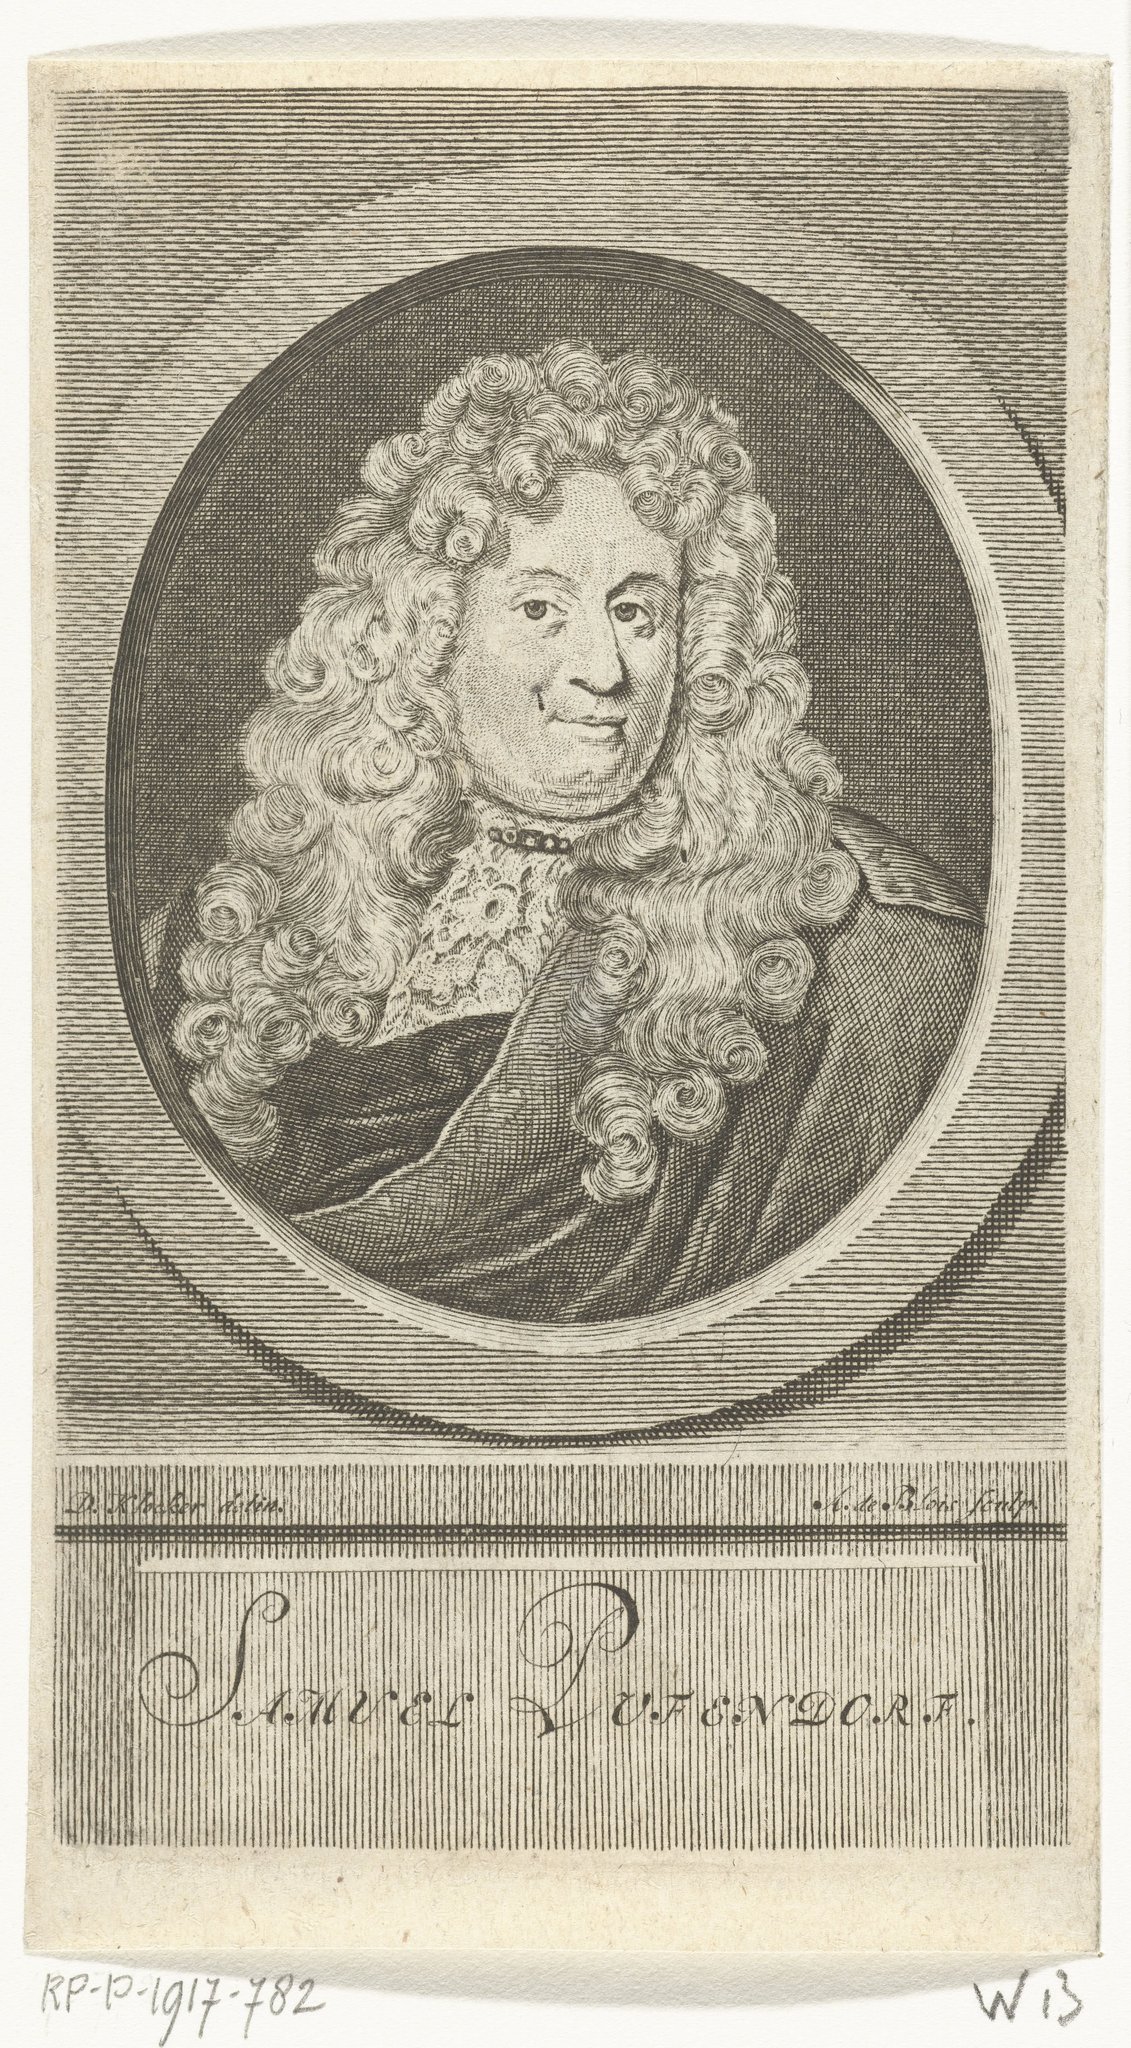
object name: print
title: Samuel Pufendorf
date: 1679-1717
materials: paper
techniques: engraving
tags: berlin, scholar, philosopher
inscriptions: collector's mark: Lugt 2228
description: Afdruk van gesleten plaat (vergelijk inv.nr. RP-P-OB-26.665).